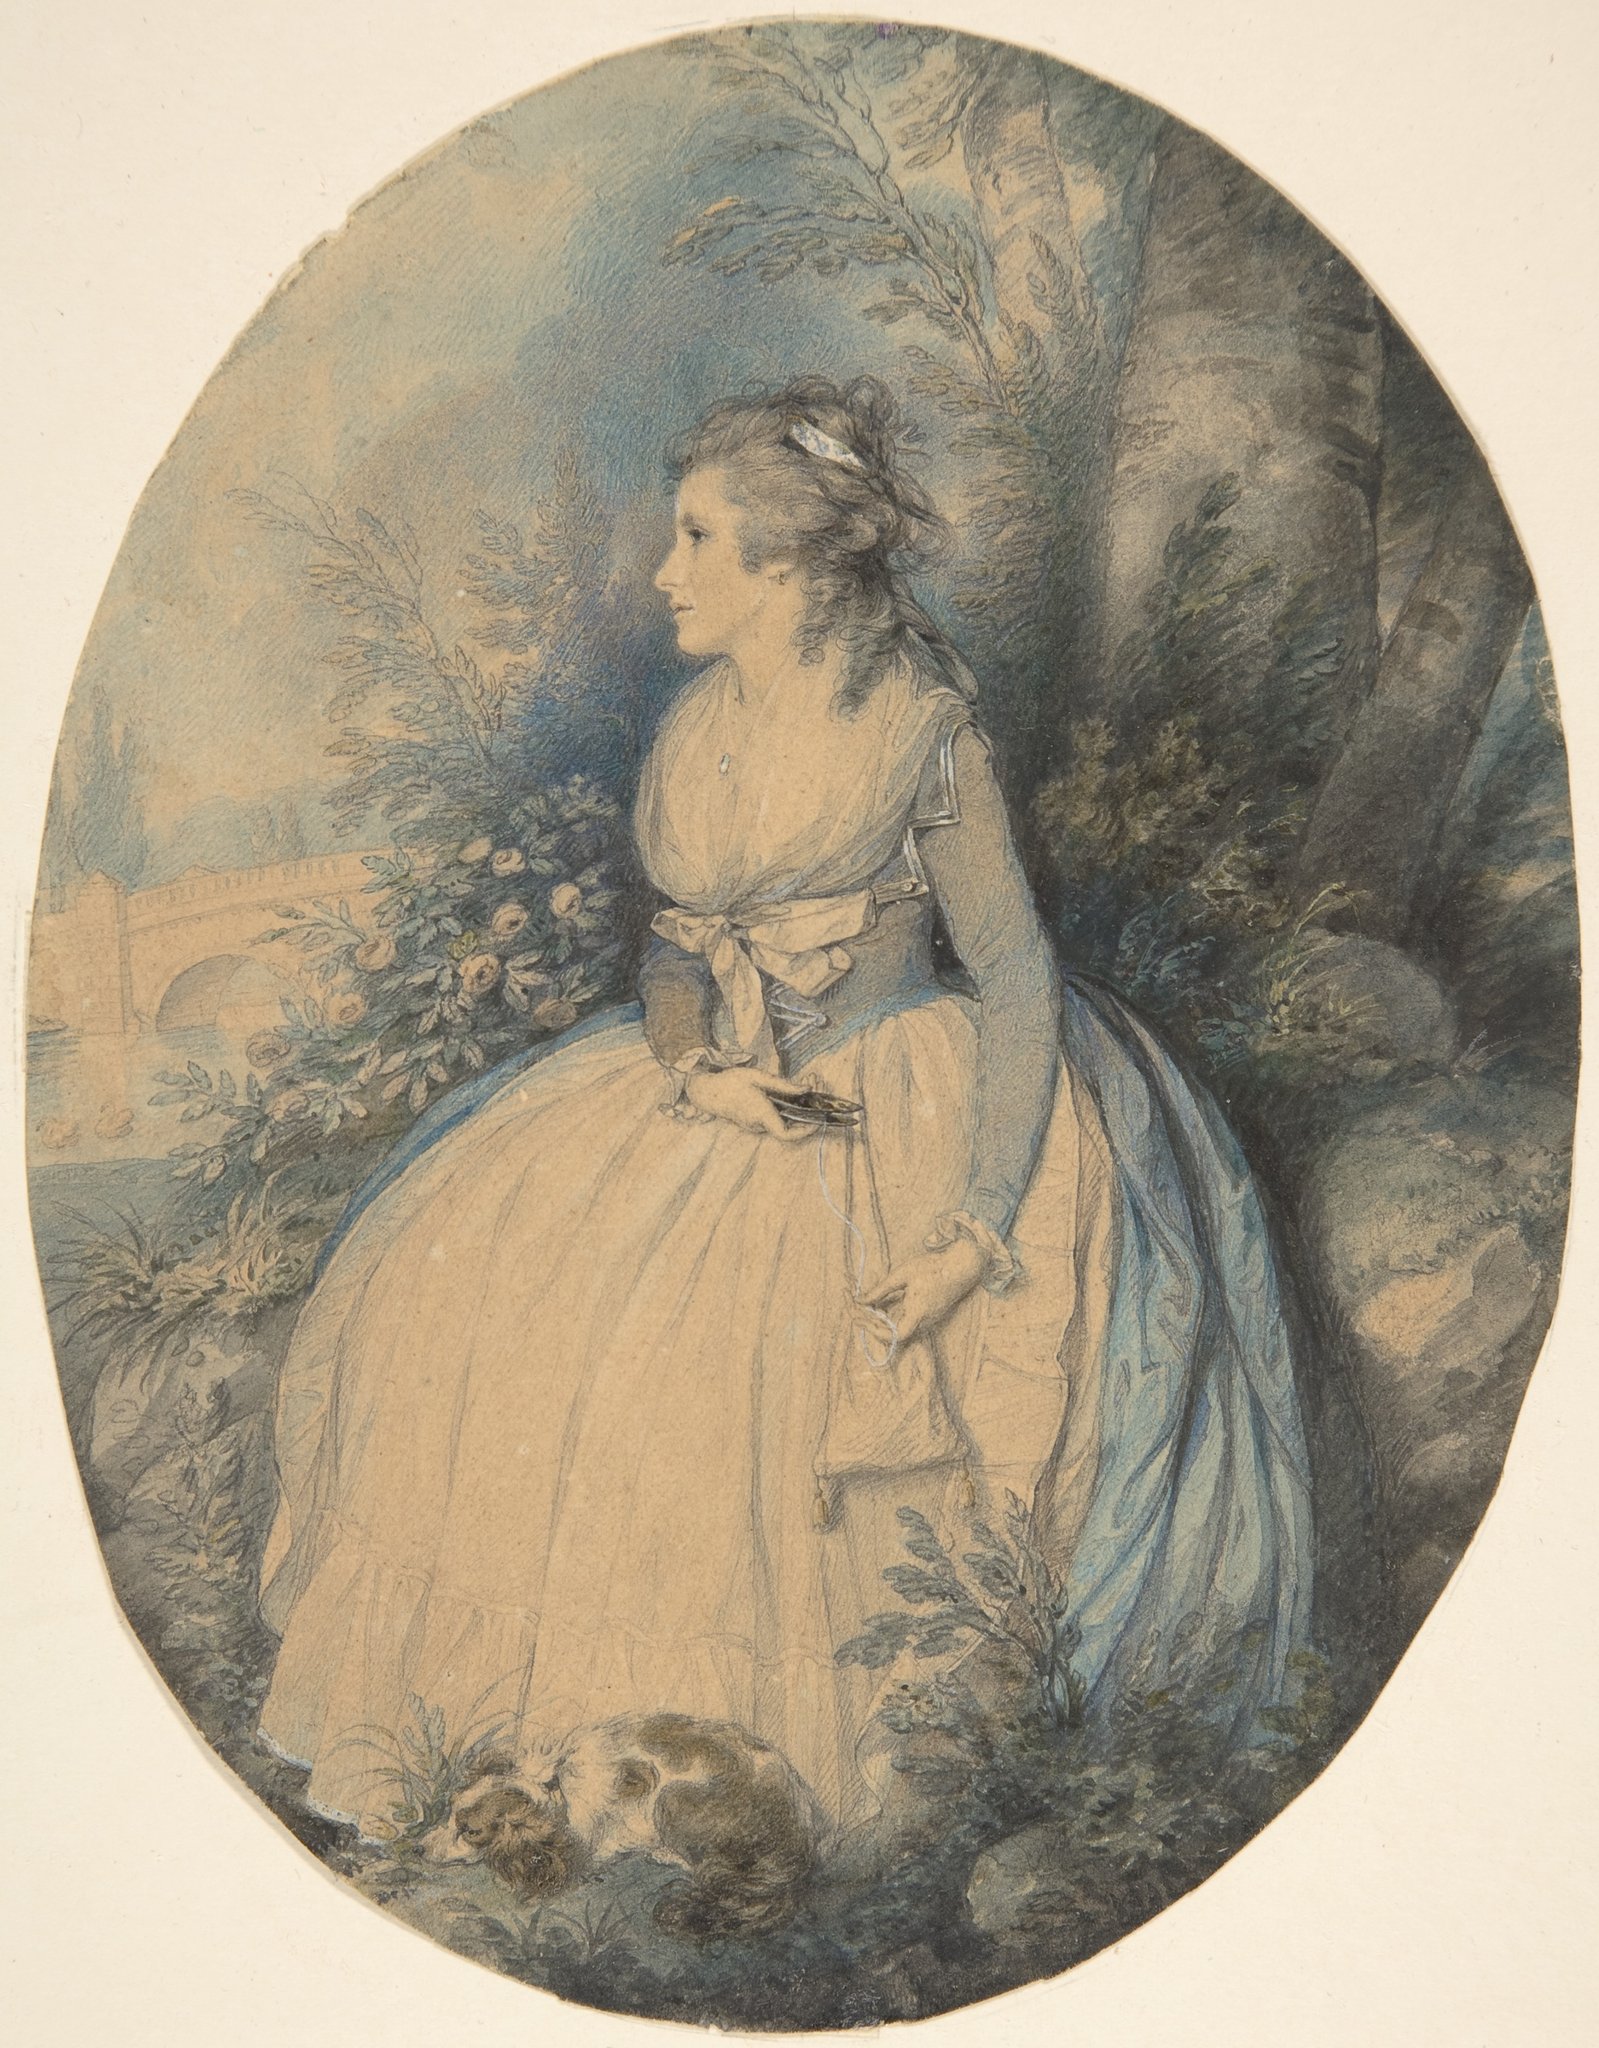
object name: drawing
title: Mrs. Robinson as Perdita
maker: richard cosway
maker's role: artist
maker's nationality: british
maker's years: 1742-1821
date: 1779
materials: chalk, gouache, graphite, watercolor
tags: shakespeare,women,dogs,actresses